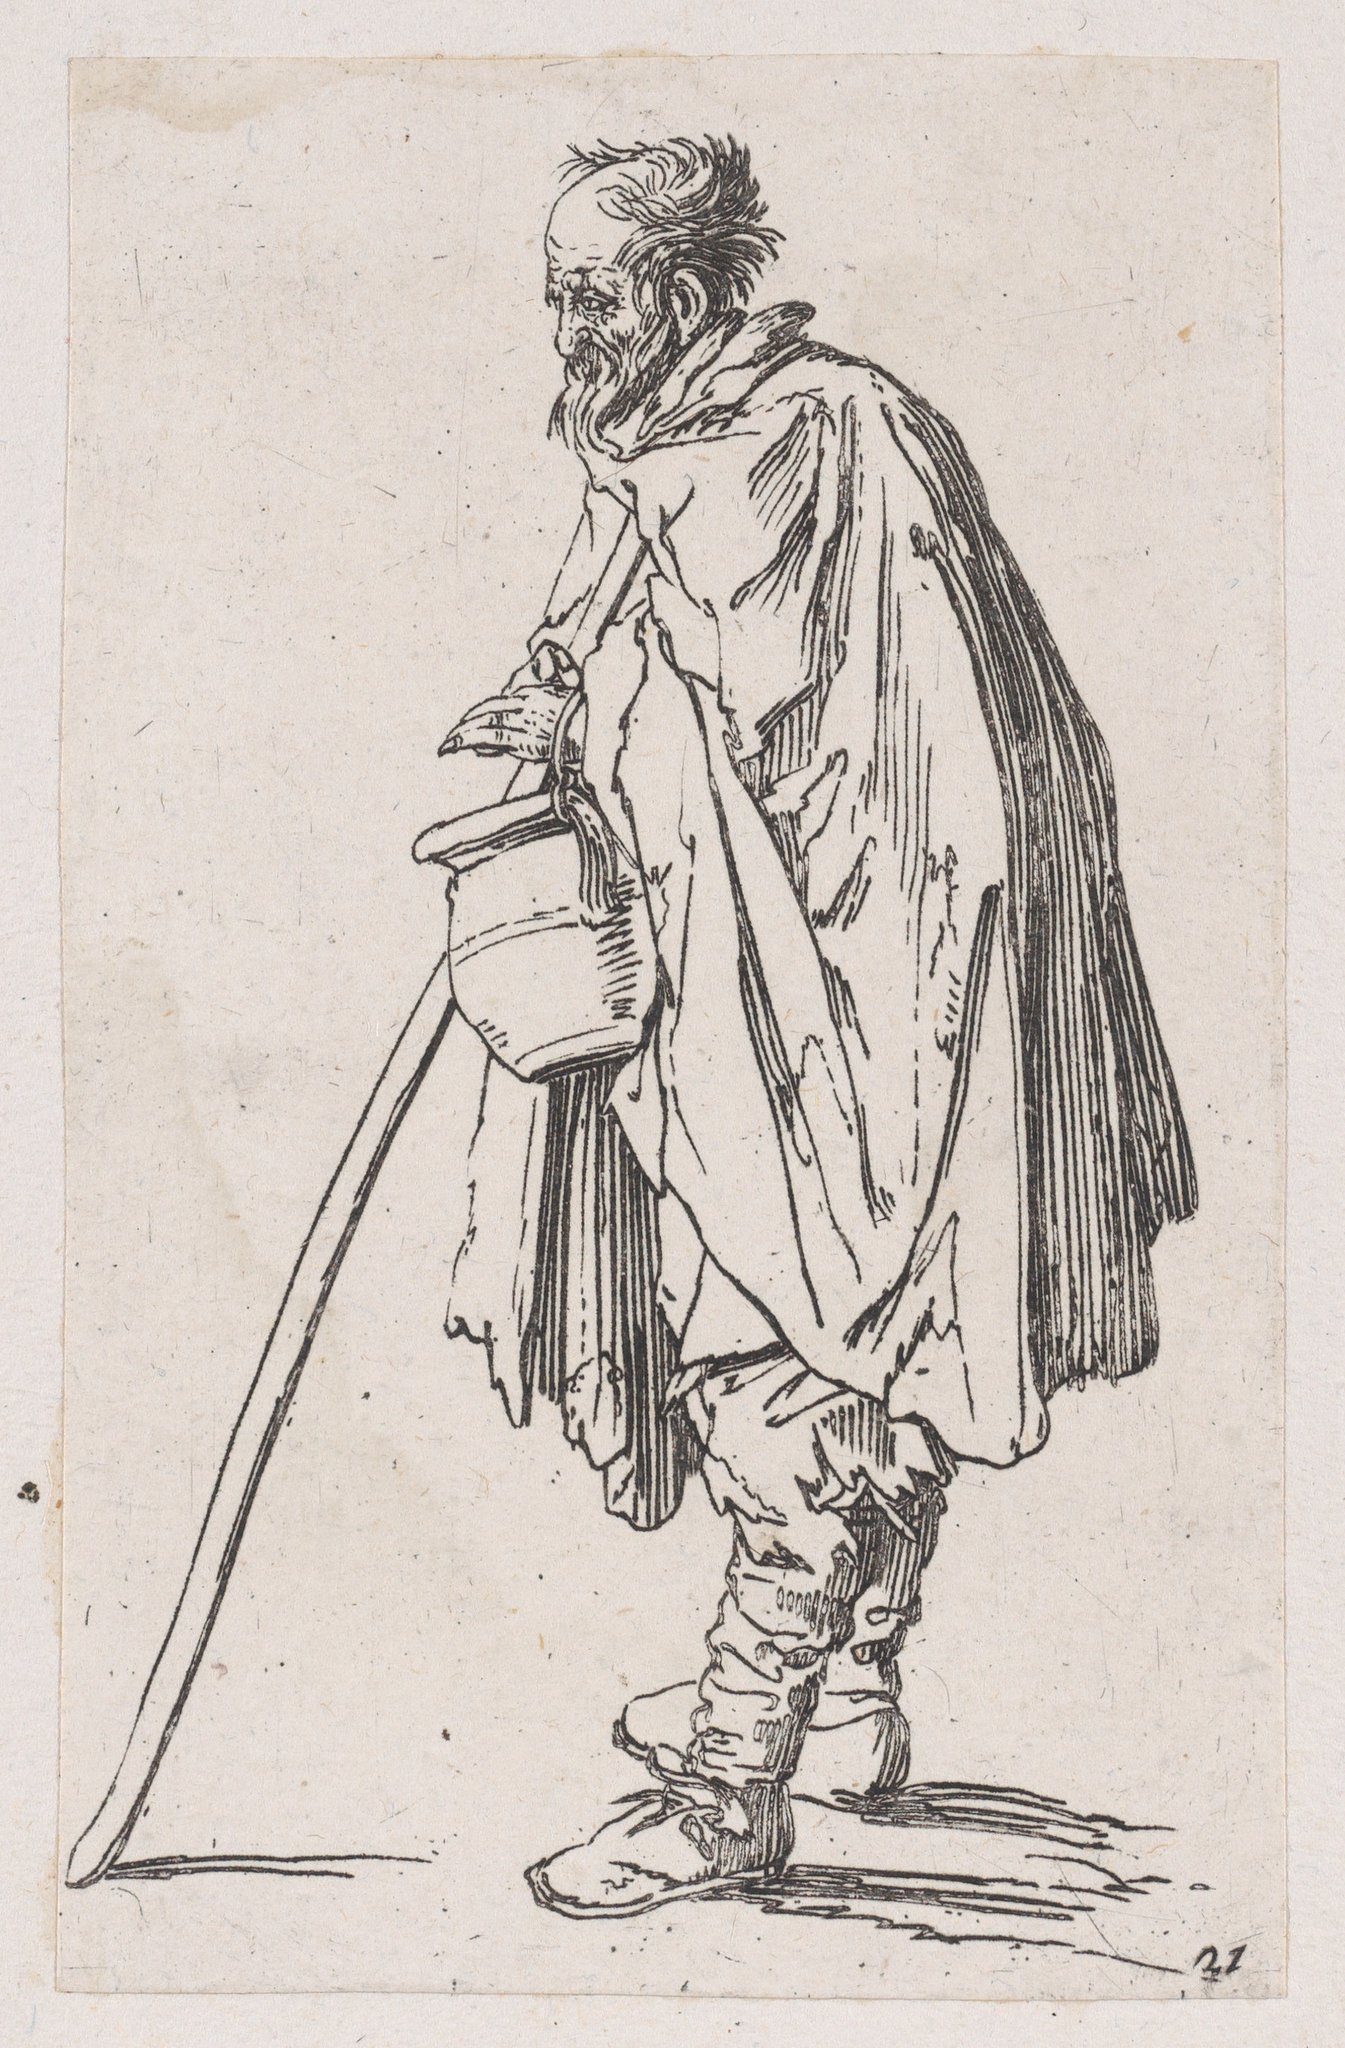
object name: print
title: Reverse Copy of Le Mendiant au Couvet (The Beggar of Couvet), from Les Gueux suite appelée aussi Les Mendiants, Les Baroni, ou Les Barons (The Beggars, also called the Barons)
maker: Anonymous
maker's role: artist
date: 1601-1700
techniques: etching